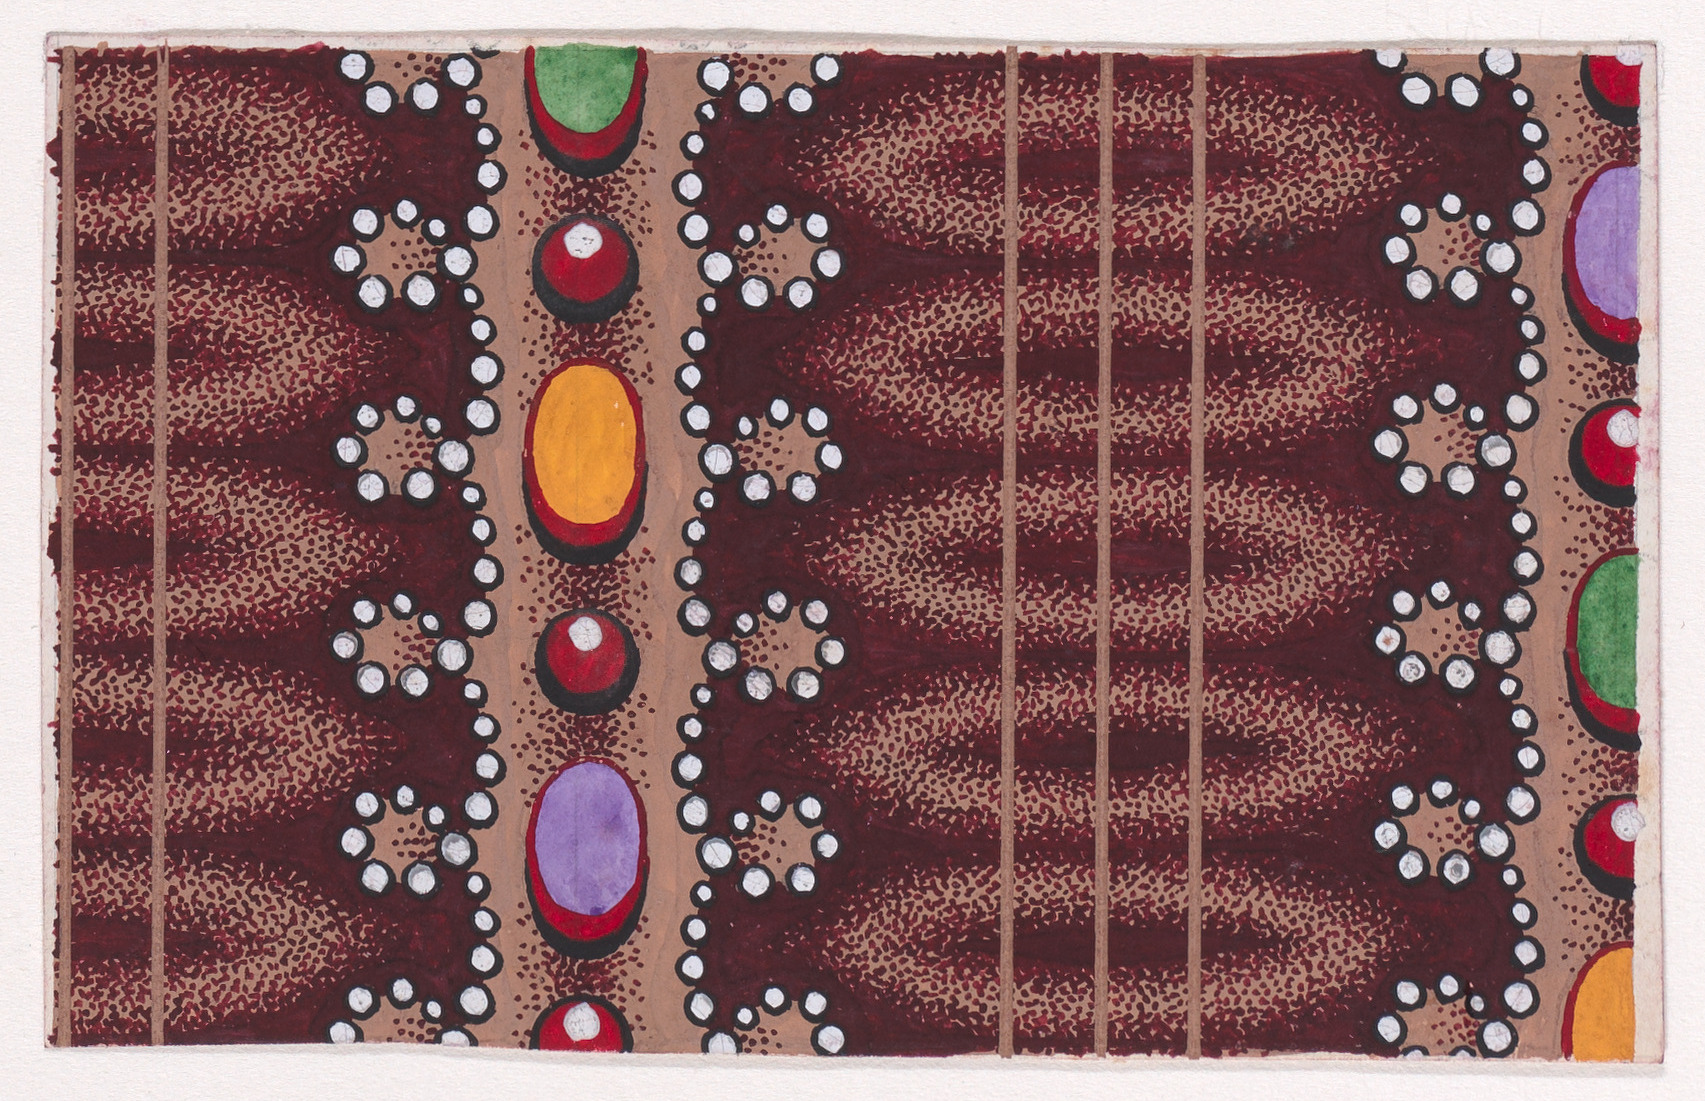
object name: drawing ornament architecture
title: Textile Design with Alternating Vertical Rows of Lens Shapes and Rows of Ovals and Pearls Framed by Undulating Garlands of Pearls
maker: anonymous, alsatian, 19th century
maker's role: artist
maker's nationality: alsatian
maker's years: 1800-1900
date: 1840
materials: gouache